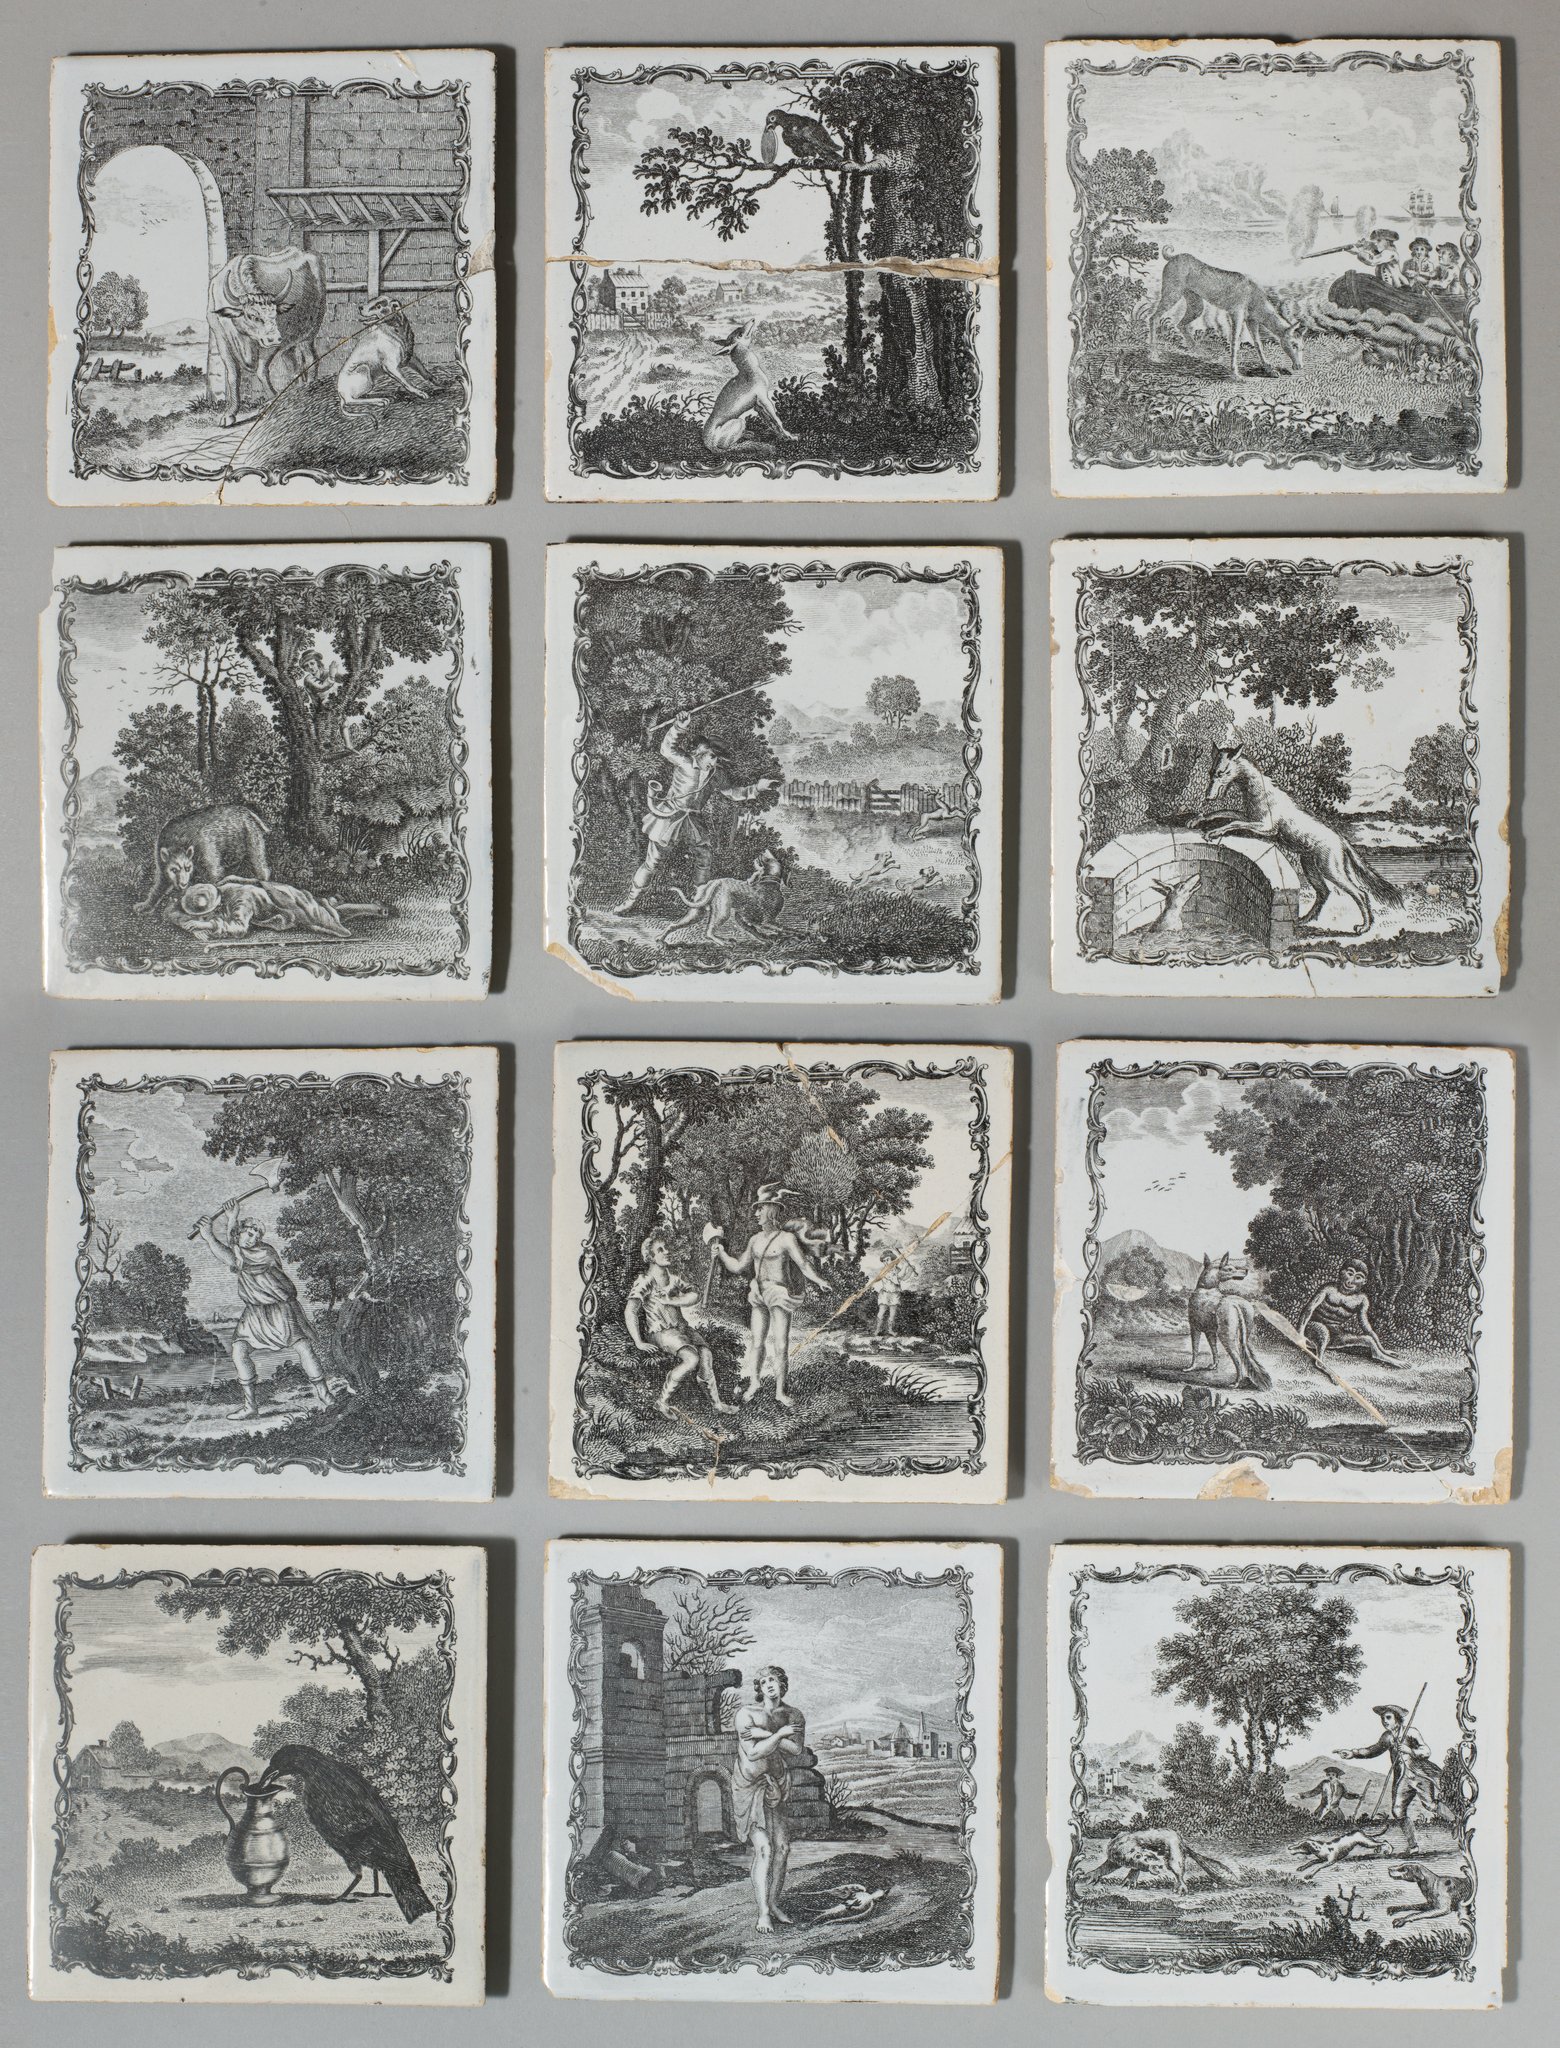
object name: tile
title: Set of twelve tiles with scenes from Aesop's Fables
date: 1760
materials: earthenware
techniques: glazing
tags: birds